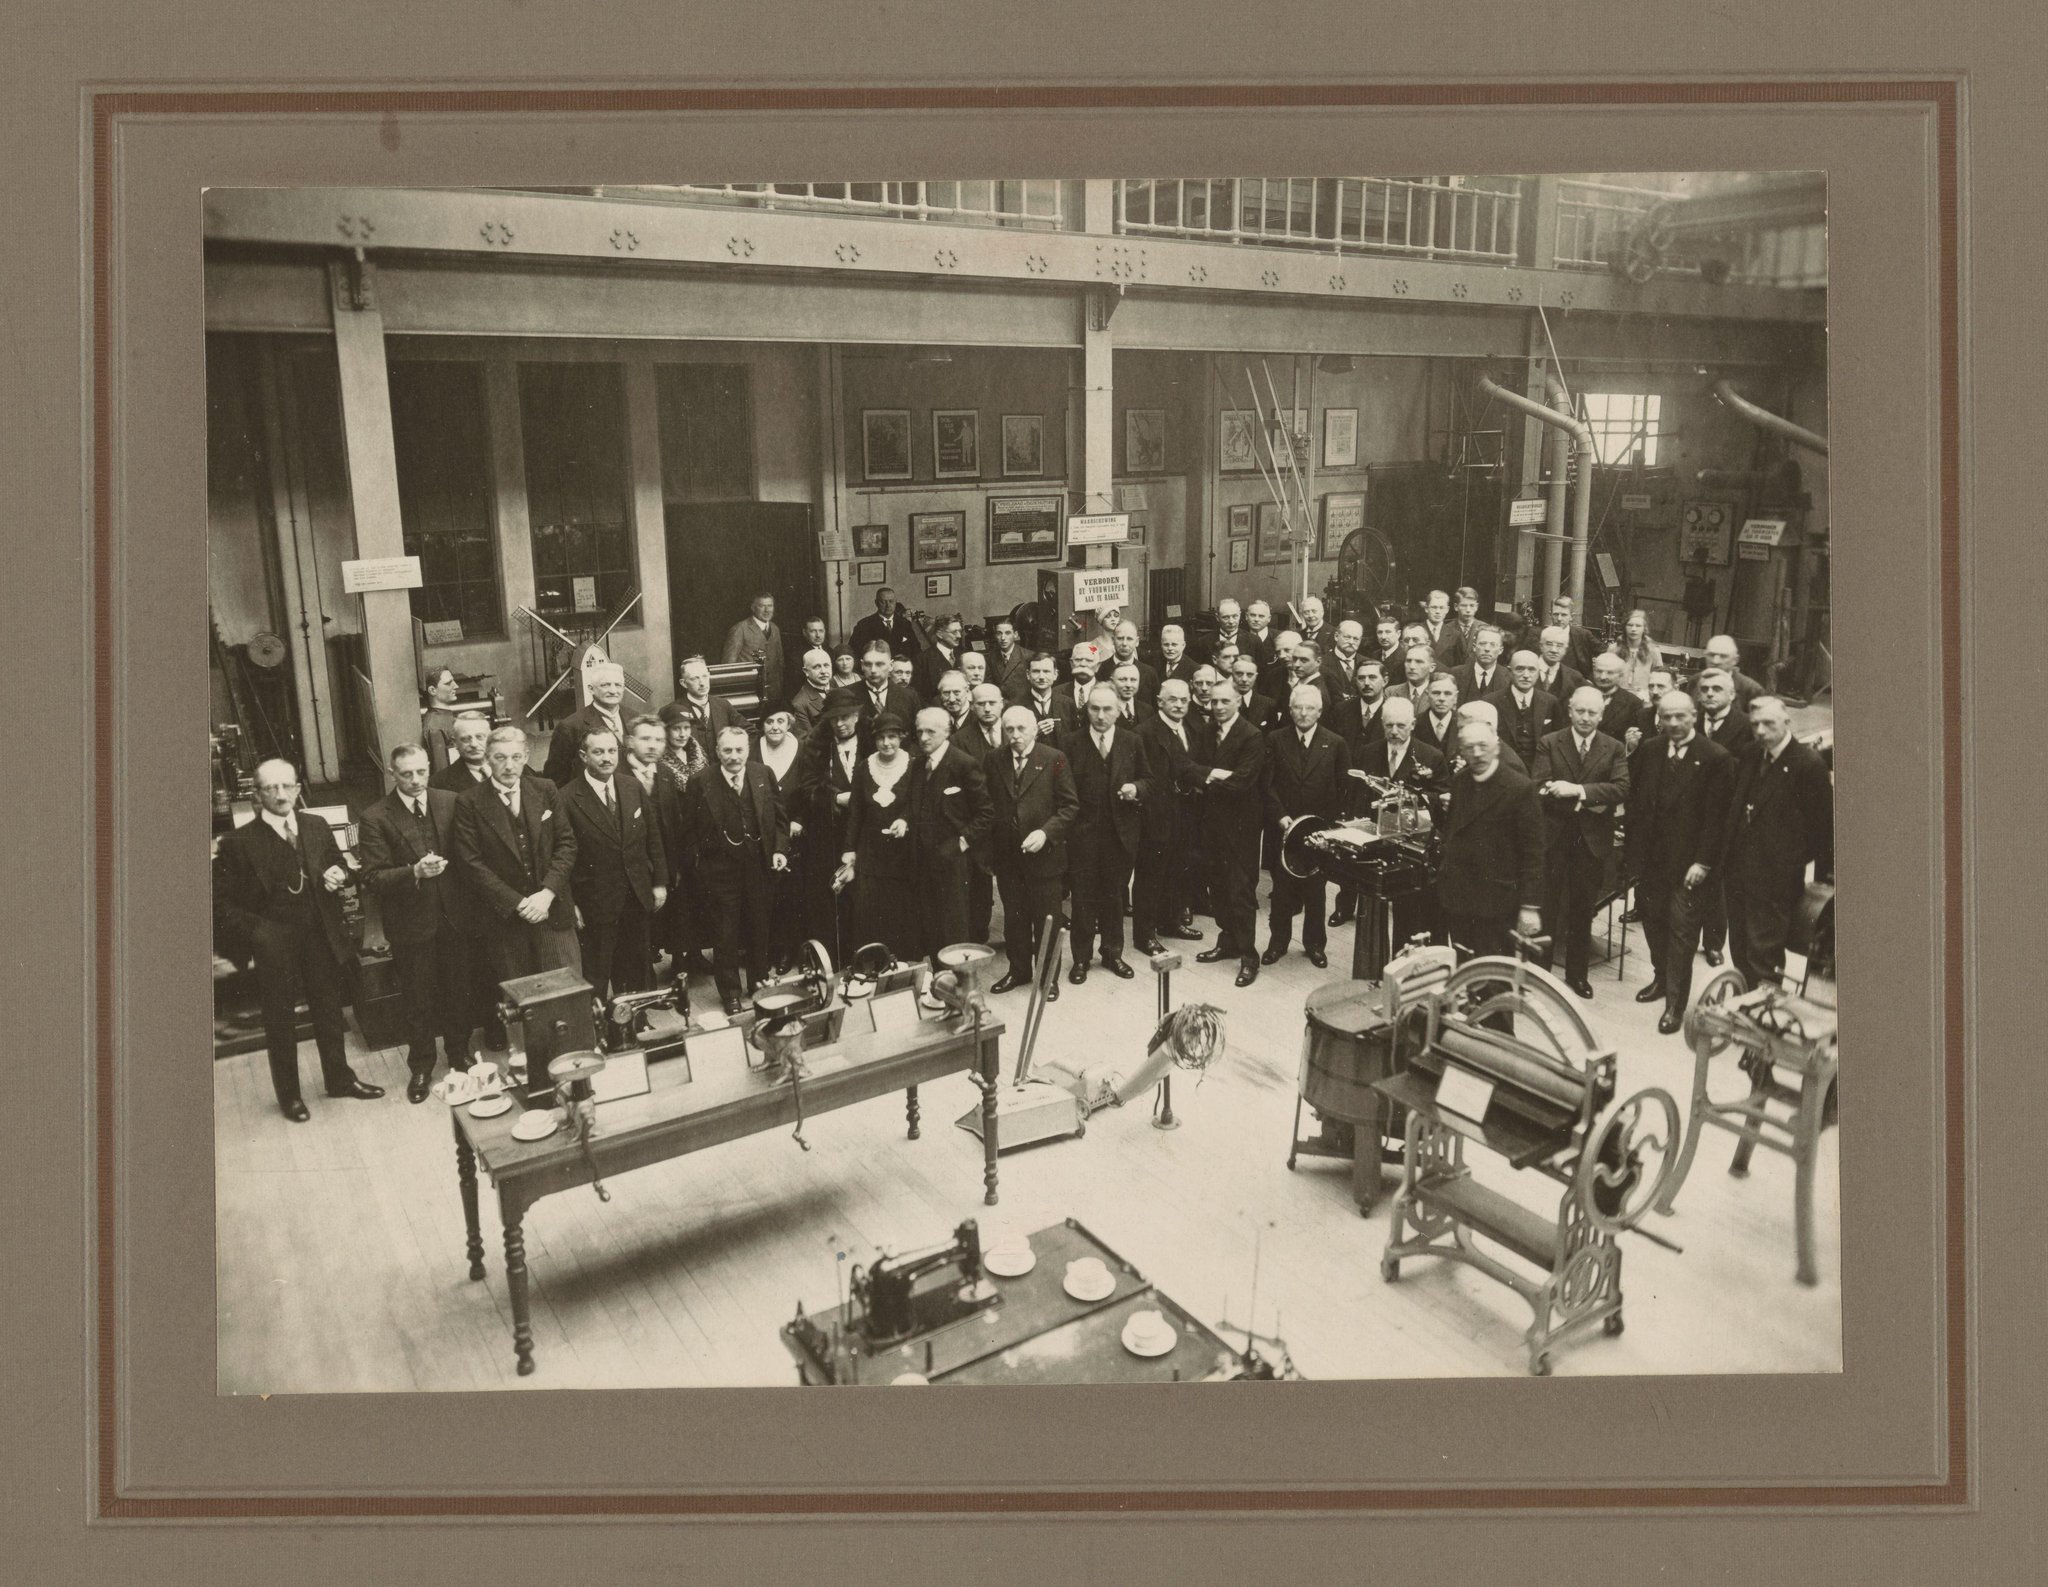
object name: photograph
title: Veertigjarig herdenking openstelling Veiligheidsmuseum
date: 1933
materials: cardboard, photographic support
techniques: gelatin silver print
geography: amsterdam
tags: amsterdam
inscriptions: annotation: ‘Veertigjarig herdenking openstelling // Veiligheidsmuseum 7 Januari 1933’, address: ‘FOTO-BUREAU LINDEMAN // WETERINGSCHANS 189 // AMSTERDAM’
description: Op de voorgrond museumobjecten, waaronder naaimachines.